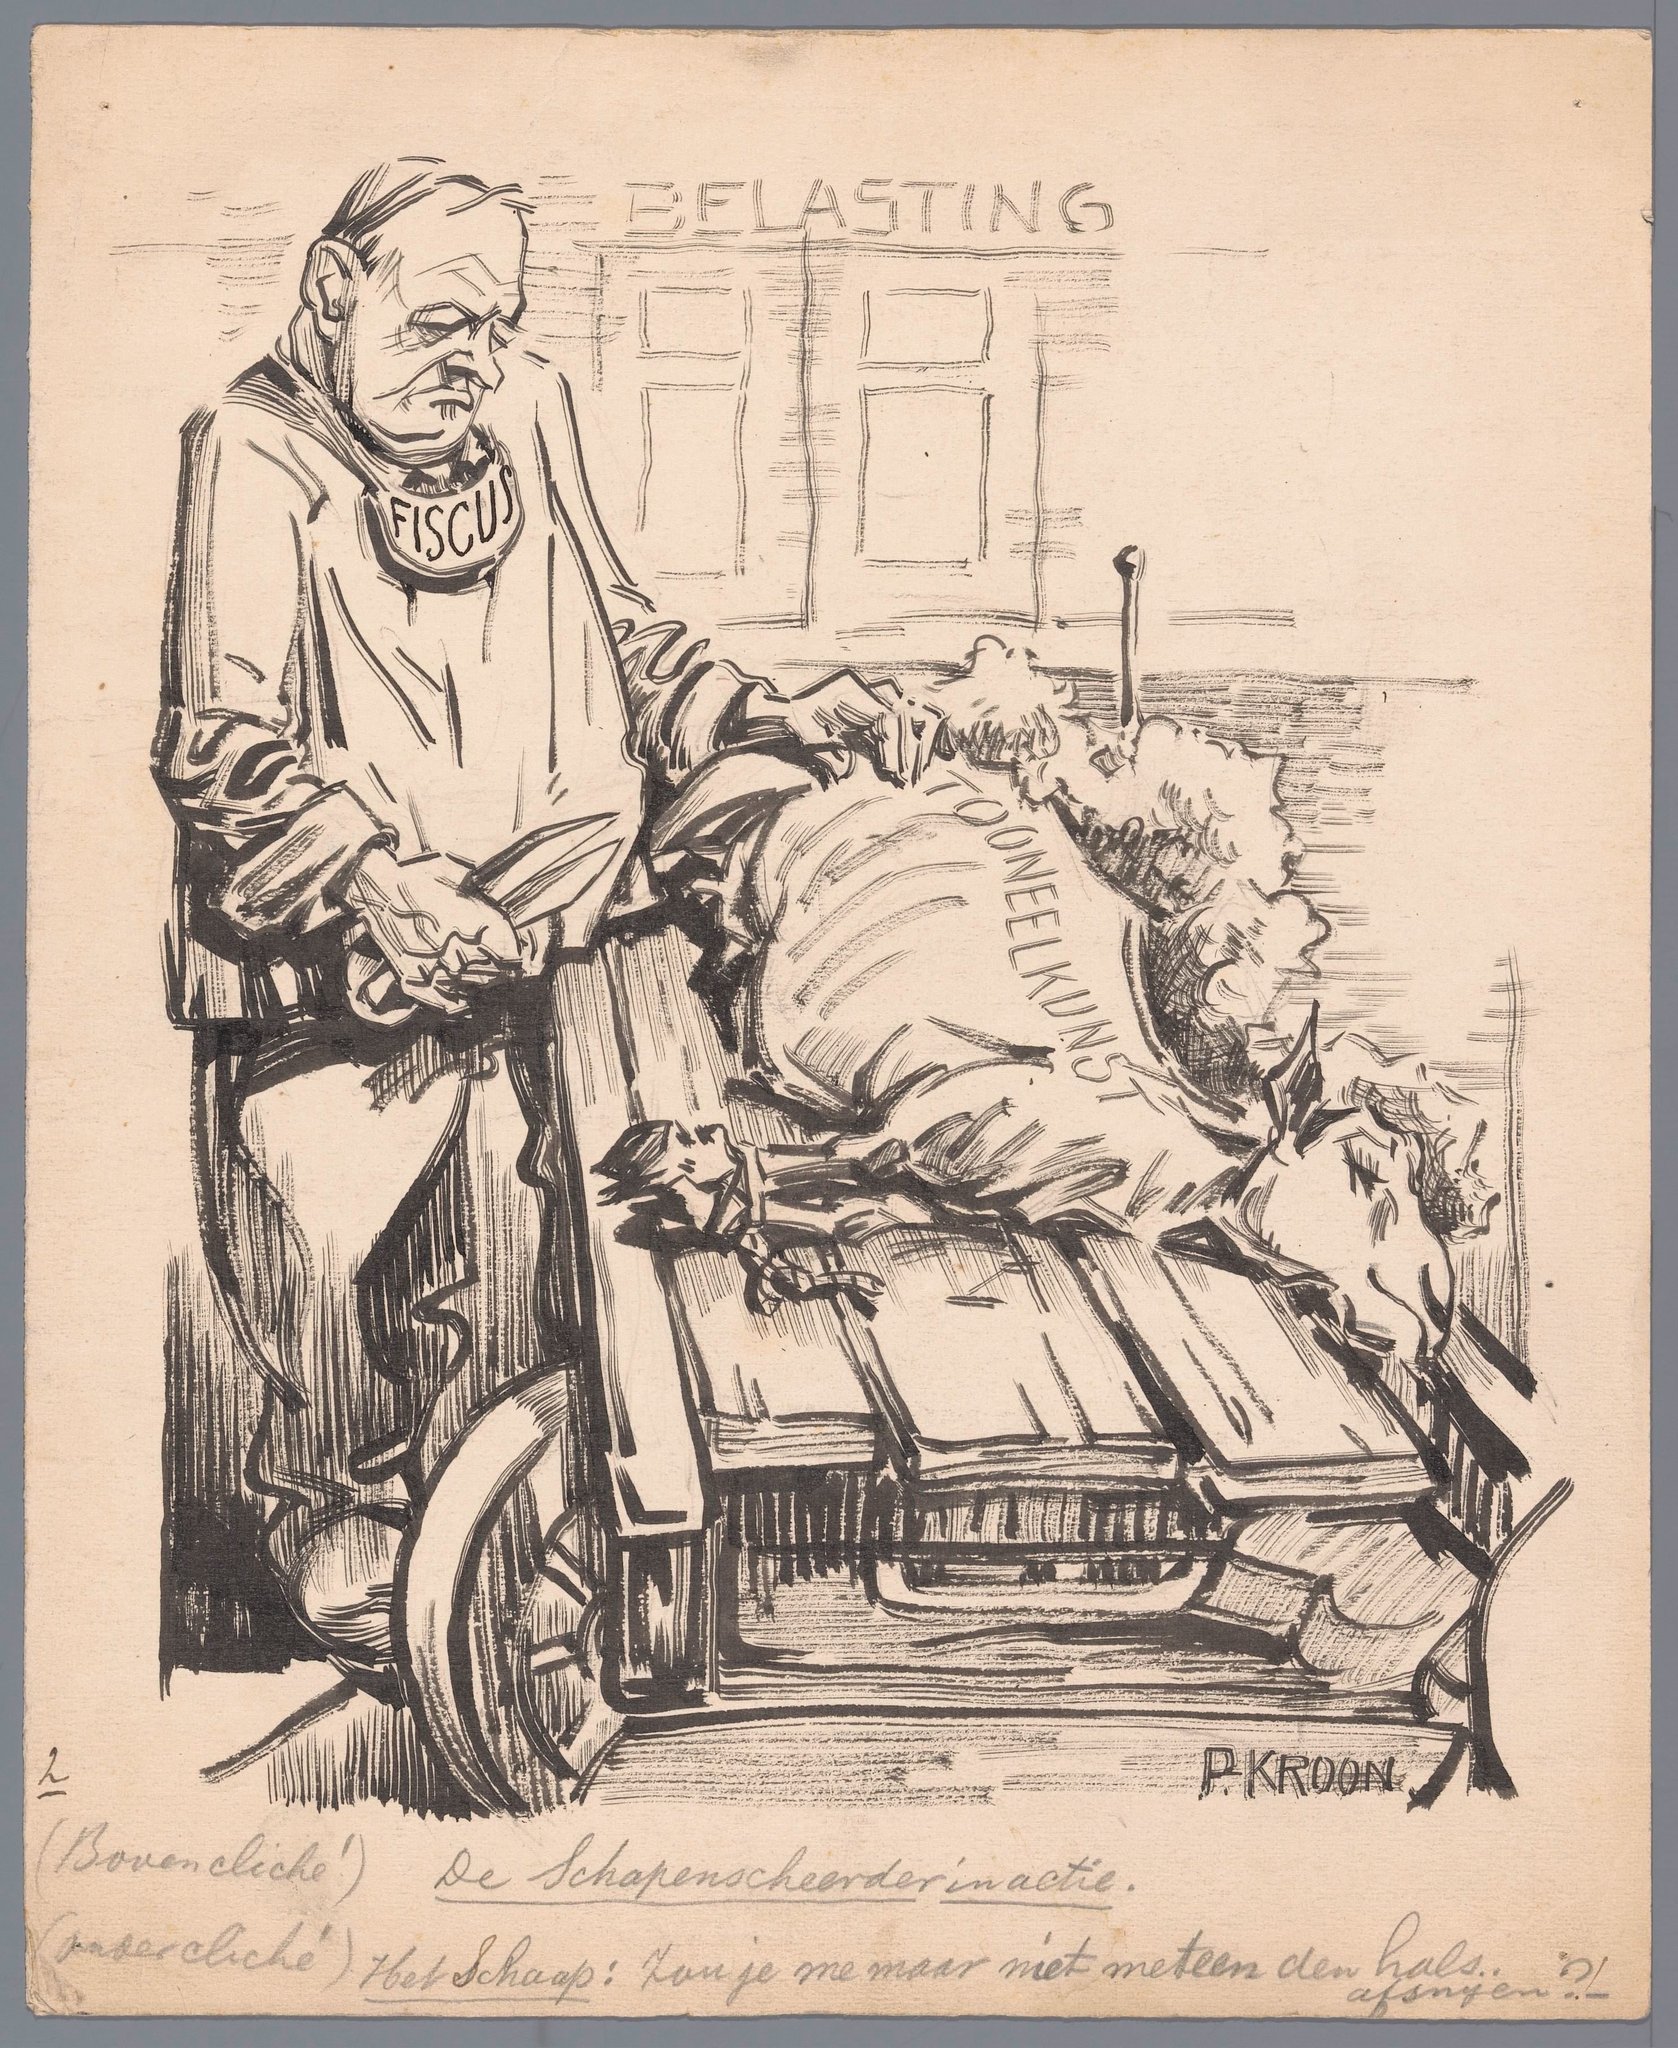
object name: drawing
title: De Schapenscheerder in actie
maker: patricq kroon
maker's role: draughtsman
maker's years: 1862-1941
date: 1900-1940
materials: paper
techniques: pen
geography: netherlands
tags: shearing (sheep), political caricatures and satires, the arts of the stage: ballet, theatre, musical drama, motion picture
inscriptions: inscription: ‘De Schapenscheerder in actie / Het Schaap: Zou je me maar niet meteen den haals afsnijden?’, number: ‘3827’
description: De fiscus scheert een schaap die de toneelkunst symboliseert. Ontwerp voor een politieke spotprent.